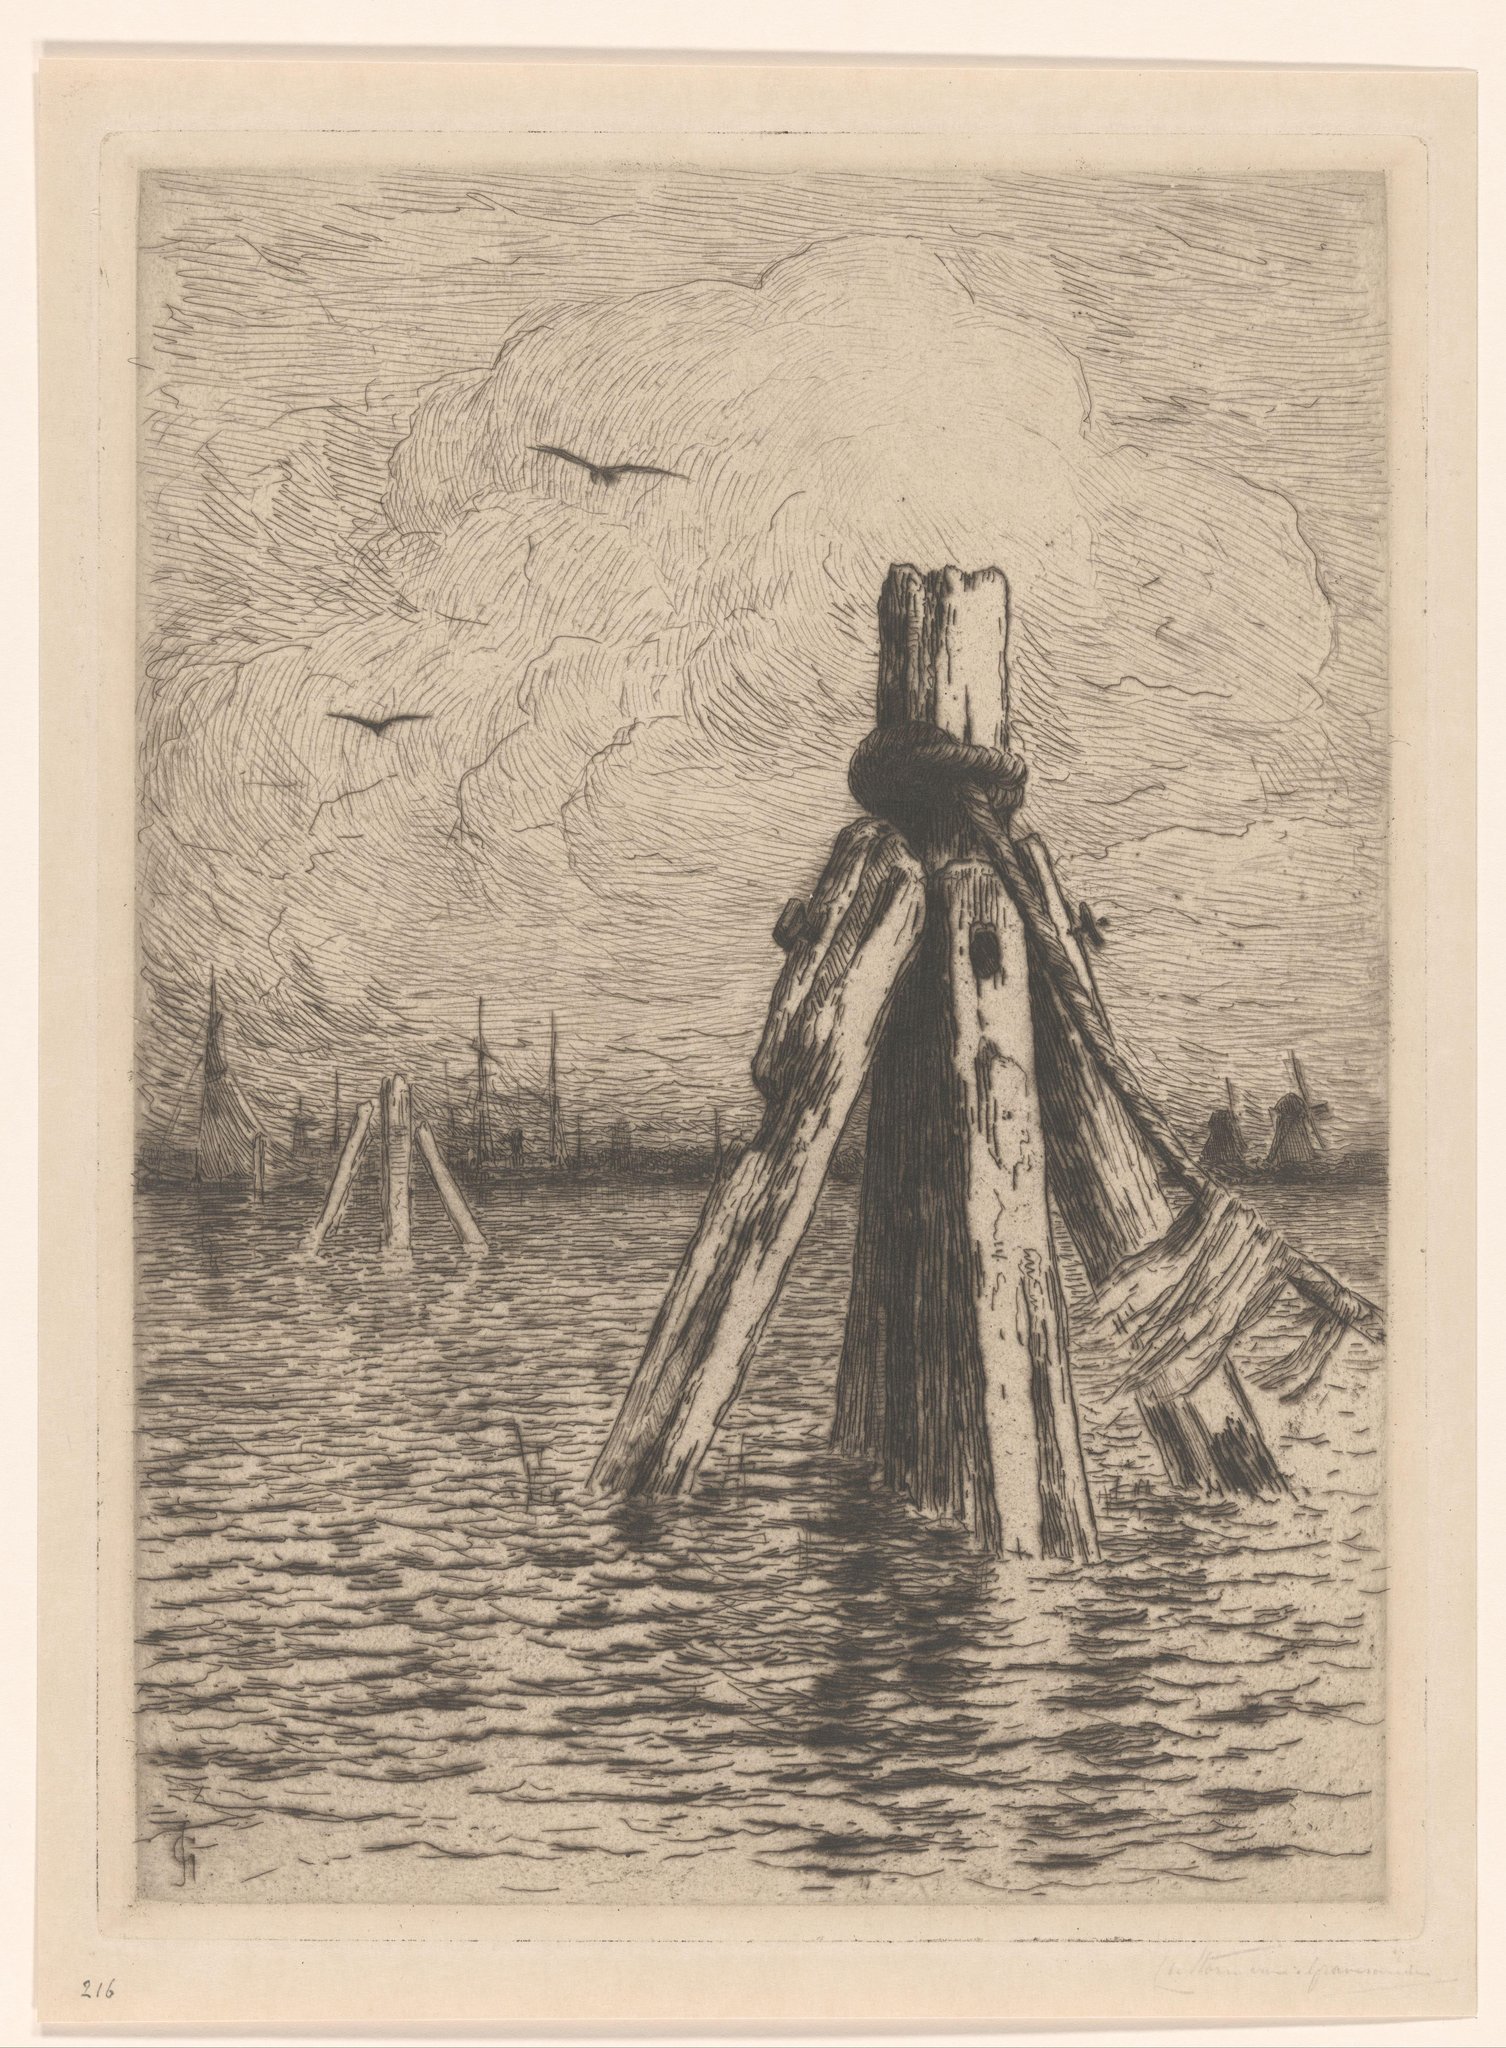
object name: print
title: Dukdalf bij Dordrecht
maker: carel nicolaas storm van s-gravesande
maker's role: draughtsman, print maker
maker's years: 1841-1924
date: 1884-1887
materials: paper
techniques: drypoint, etching, intaglio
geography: netherlands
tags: mooring-buoy, bollard, dordrecht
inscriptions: collector's mark: Lugt 2228